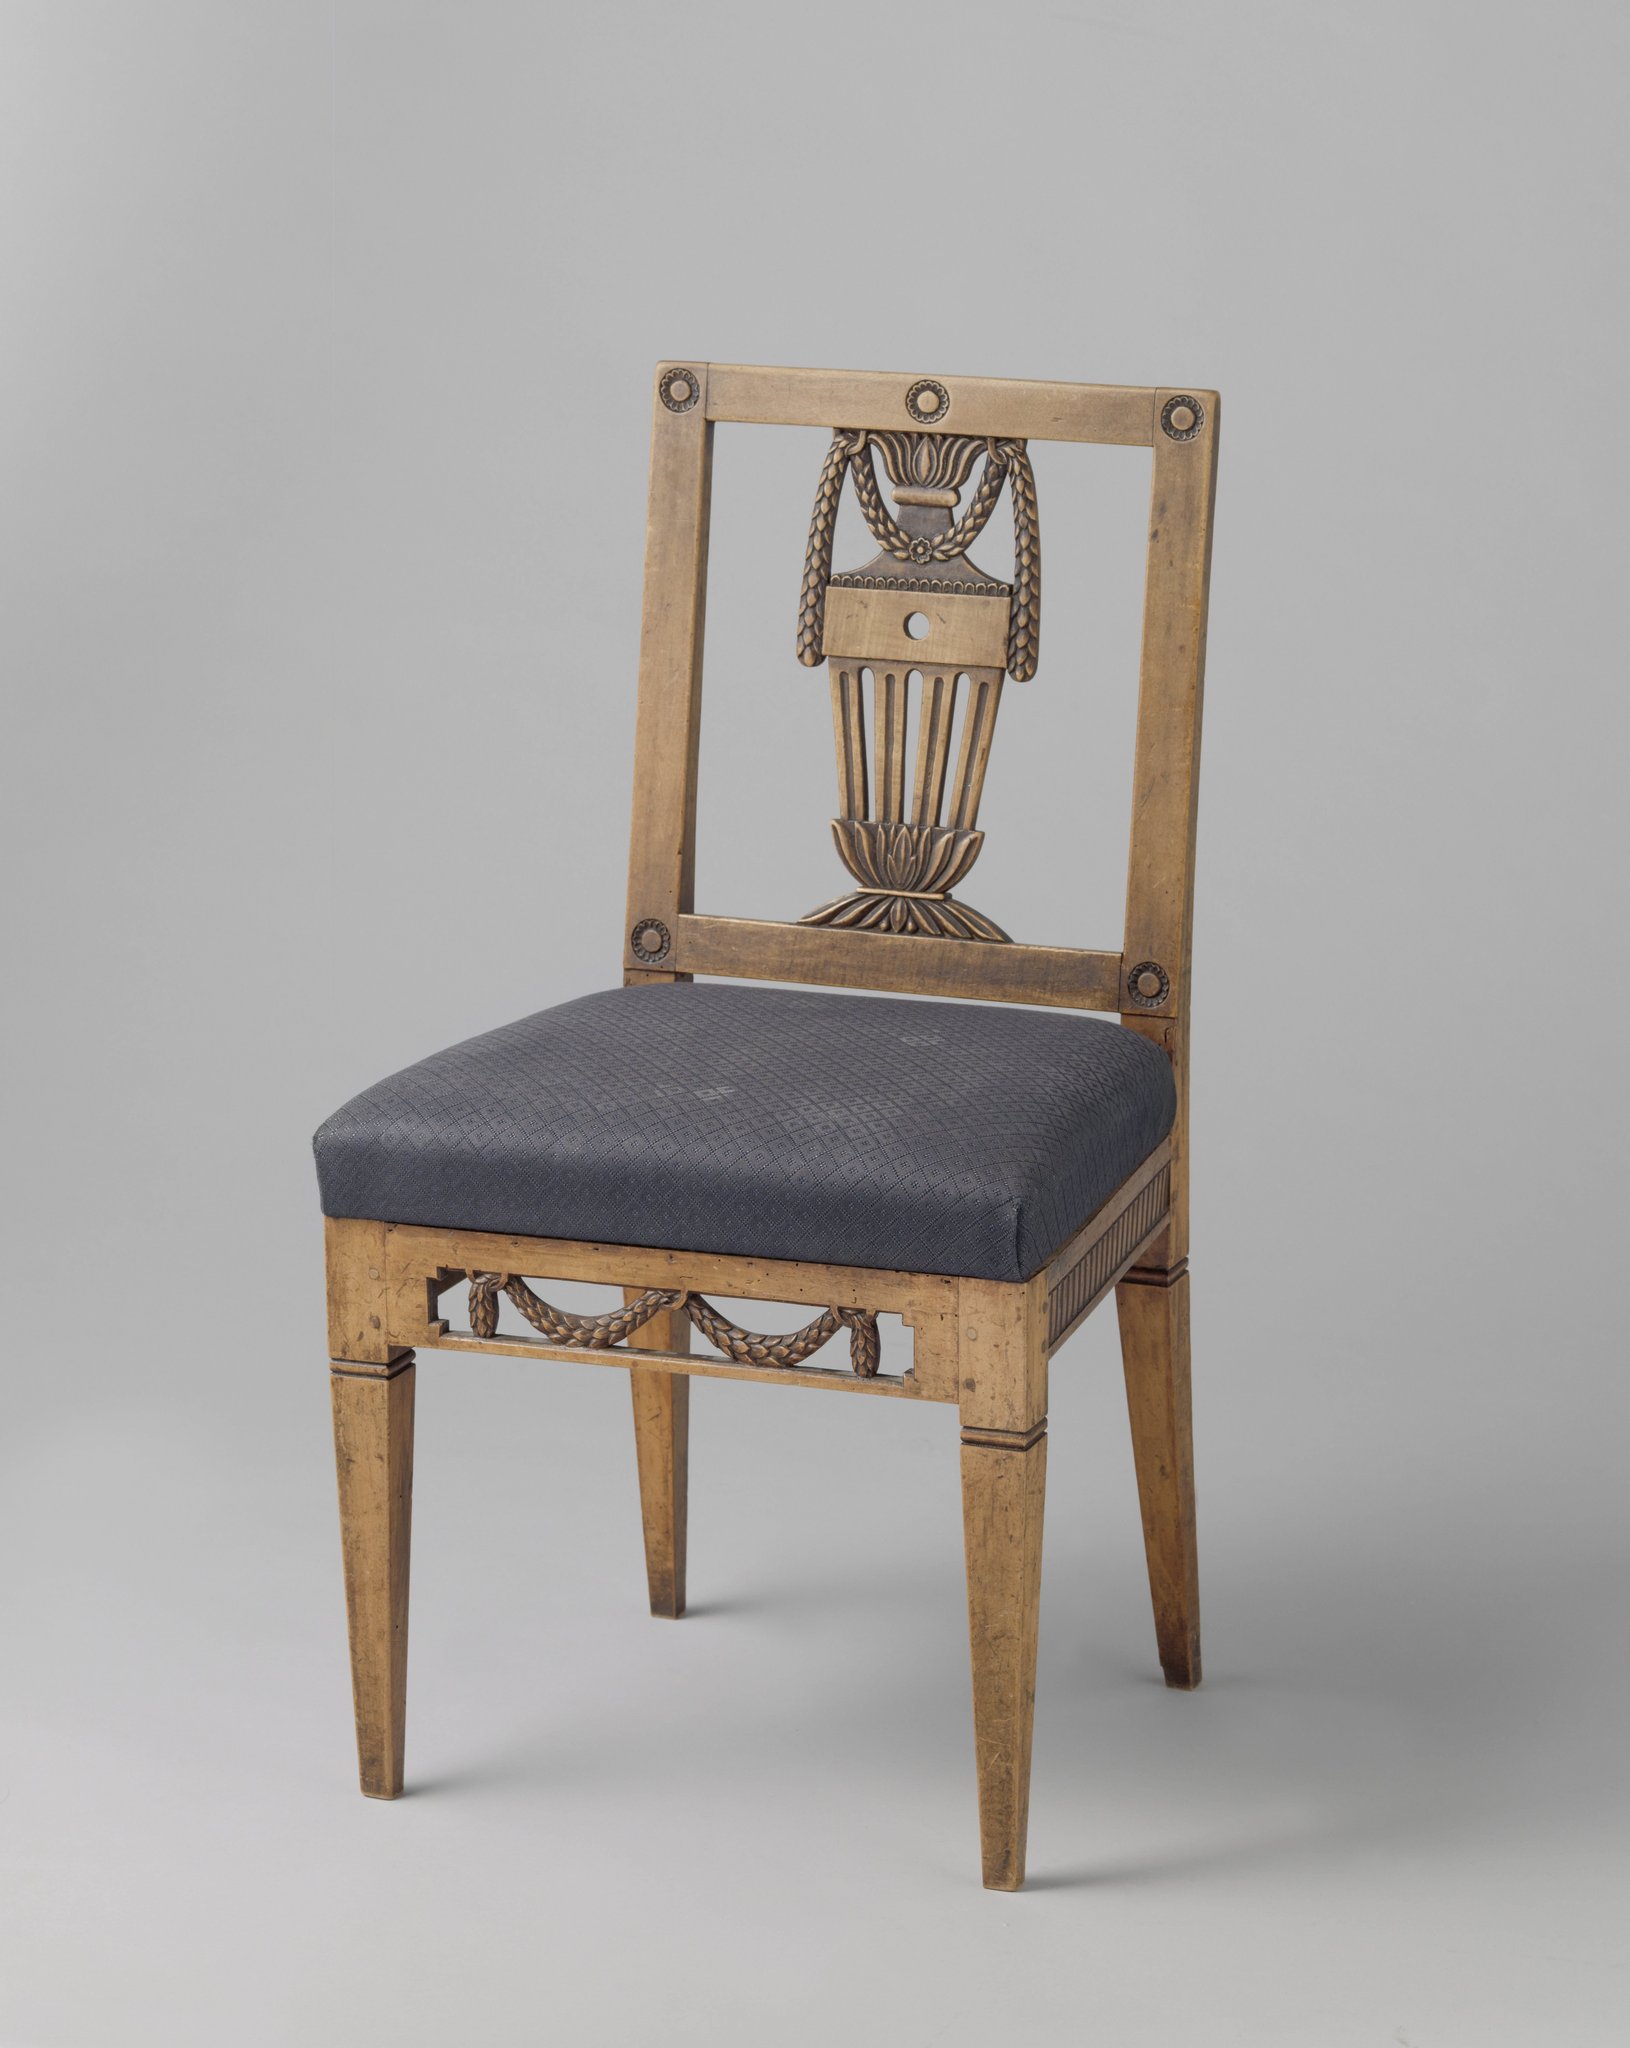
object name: furniture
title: Stoel van kersen(?)hout, met beklede zitting, rechthoekig rugraam met opengewerkte vaas met guirlandes en rozetten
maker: Anonymous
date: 1785-1800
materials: wood, textile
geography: northern netherlands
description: Stoel van kersenhout met een beklede zitting en rustend op conische poten, waarvan de achterpoten iets wijken. Het rechthoekige rugraam is open en vertoont een opengewerkt vaasmotief met guirlandes, geplaatst boven rozetten, op de hoeken en in het midden. De zitregel is aan de voorkant versierd met guirlandes binnen een rechthoekig open veld, en aan de zijkant met een tandmotief.